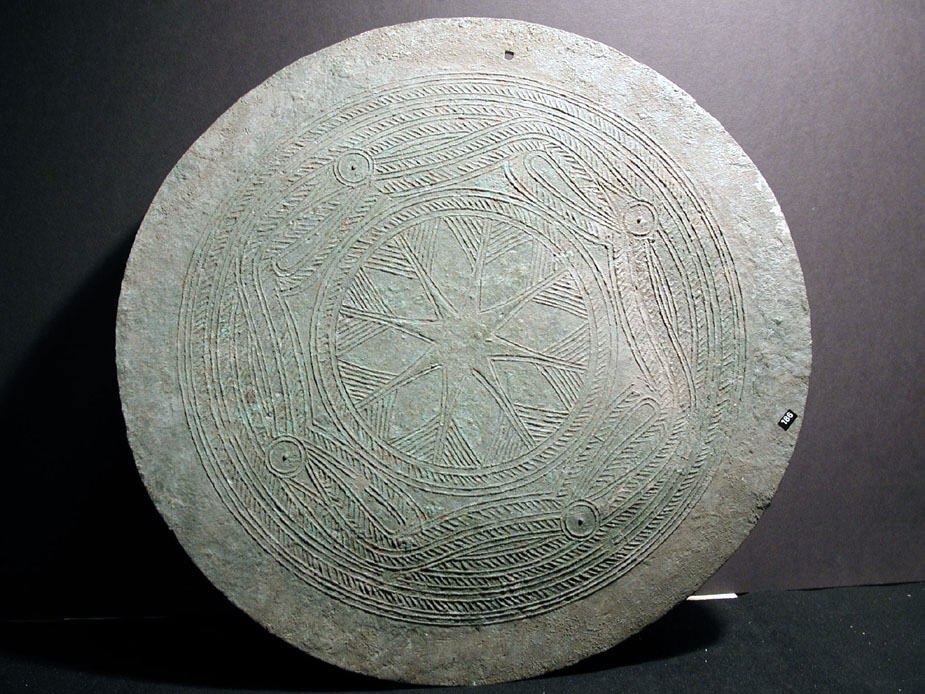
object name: tympanum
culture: indonesian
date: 500 BCE-300 CE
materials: bronze